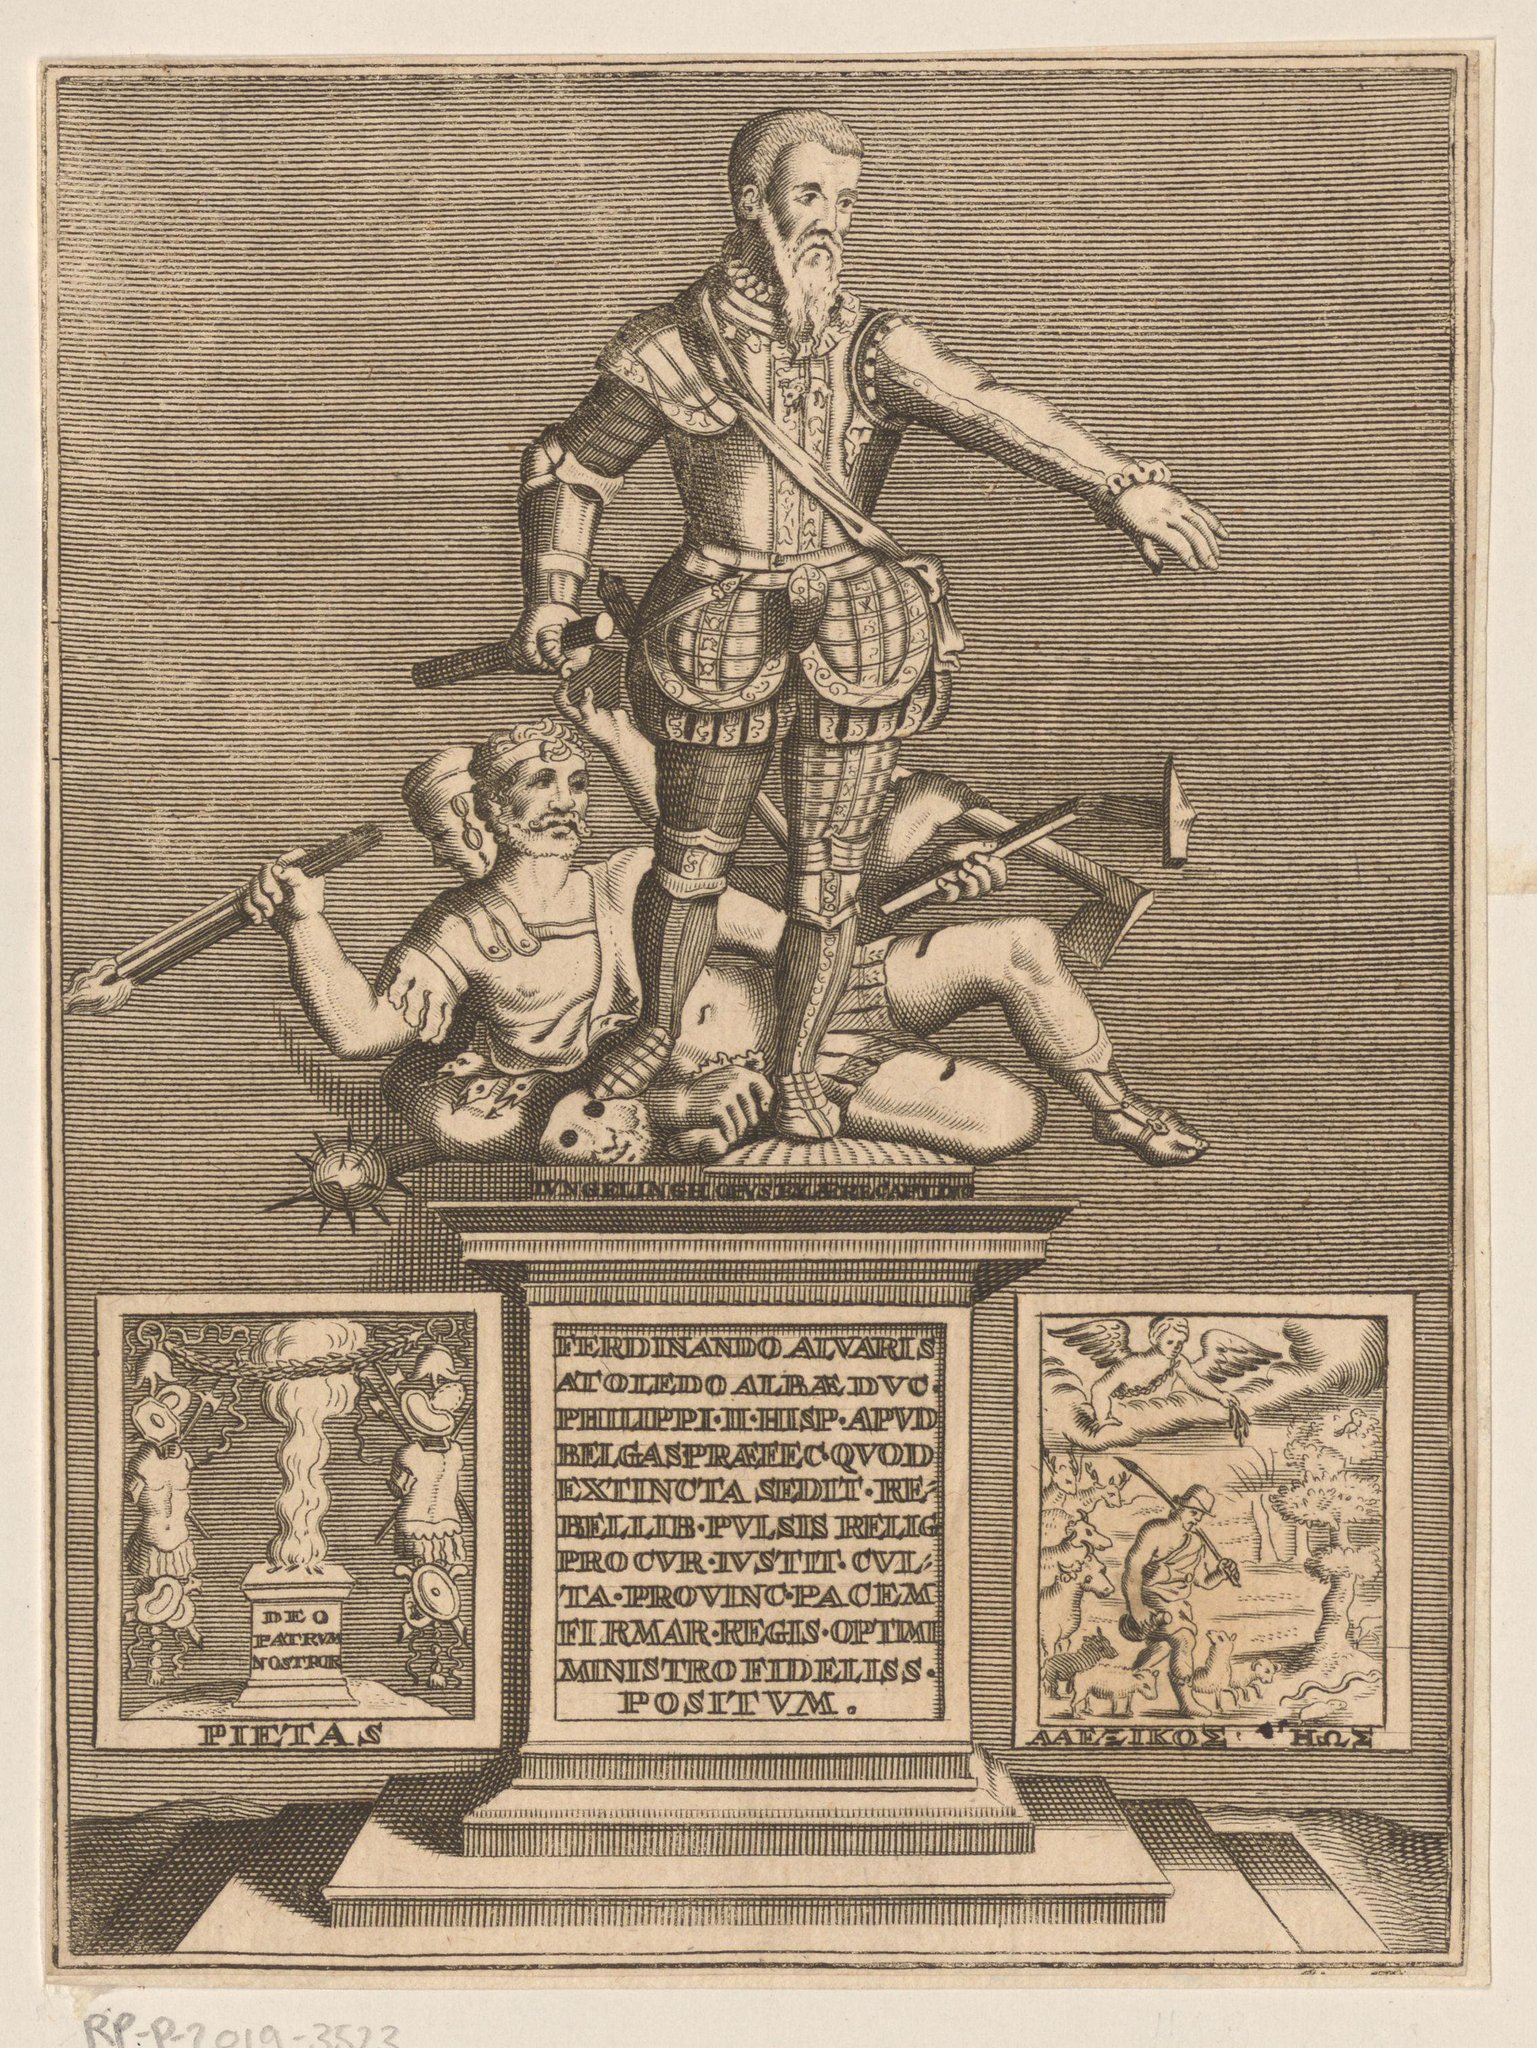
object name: print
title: Standbeeld van Fernando Álvarez de Toledo, hertog van Alva, 1571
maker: Anonymous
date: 1600-1699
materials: paper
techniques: engraving, etching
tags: fernando álvarez de toledo (3rd duke of alba), armour, historical persons, piece of sculpture, reproduction of a piece of sculpture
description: Met om zijn nek de keten van de Orde van het Gulden Vlies. Oorspronkelijk rechtsonder genummerd: fig: P., hier weggesneden.